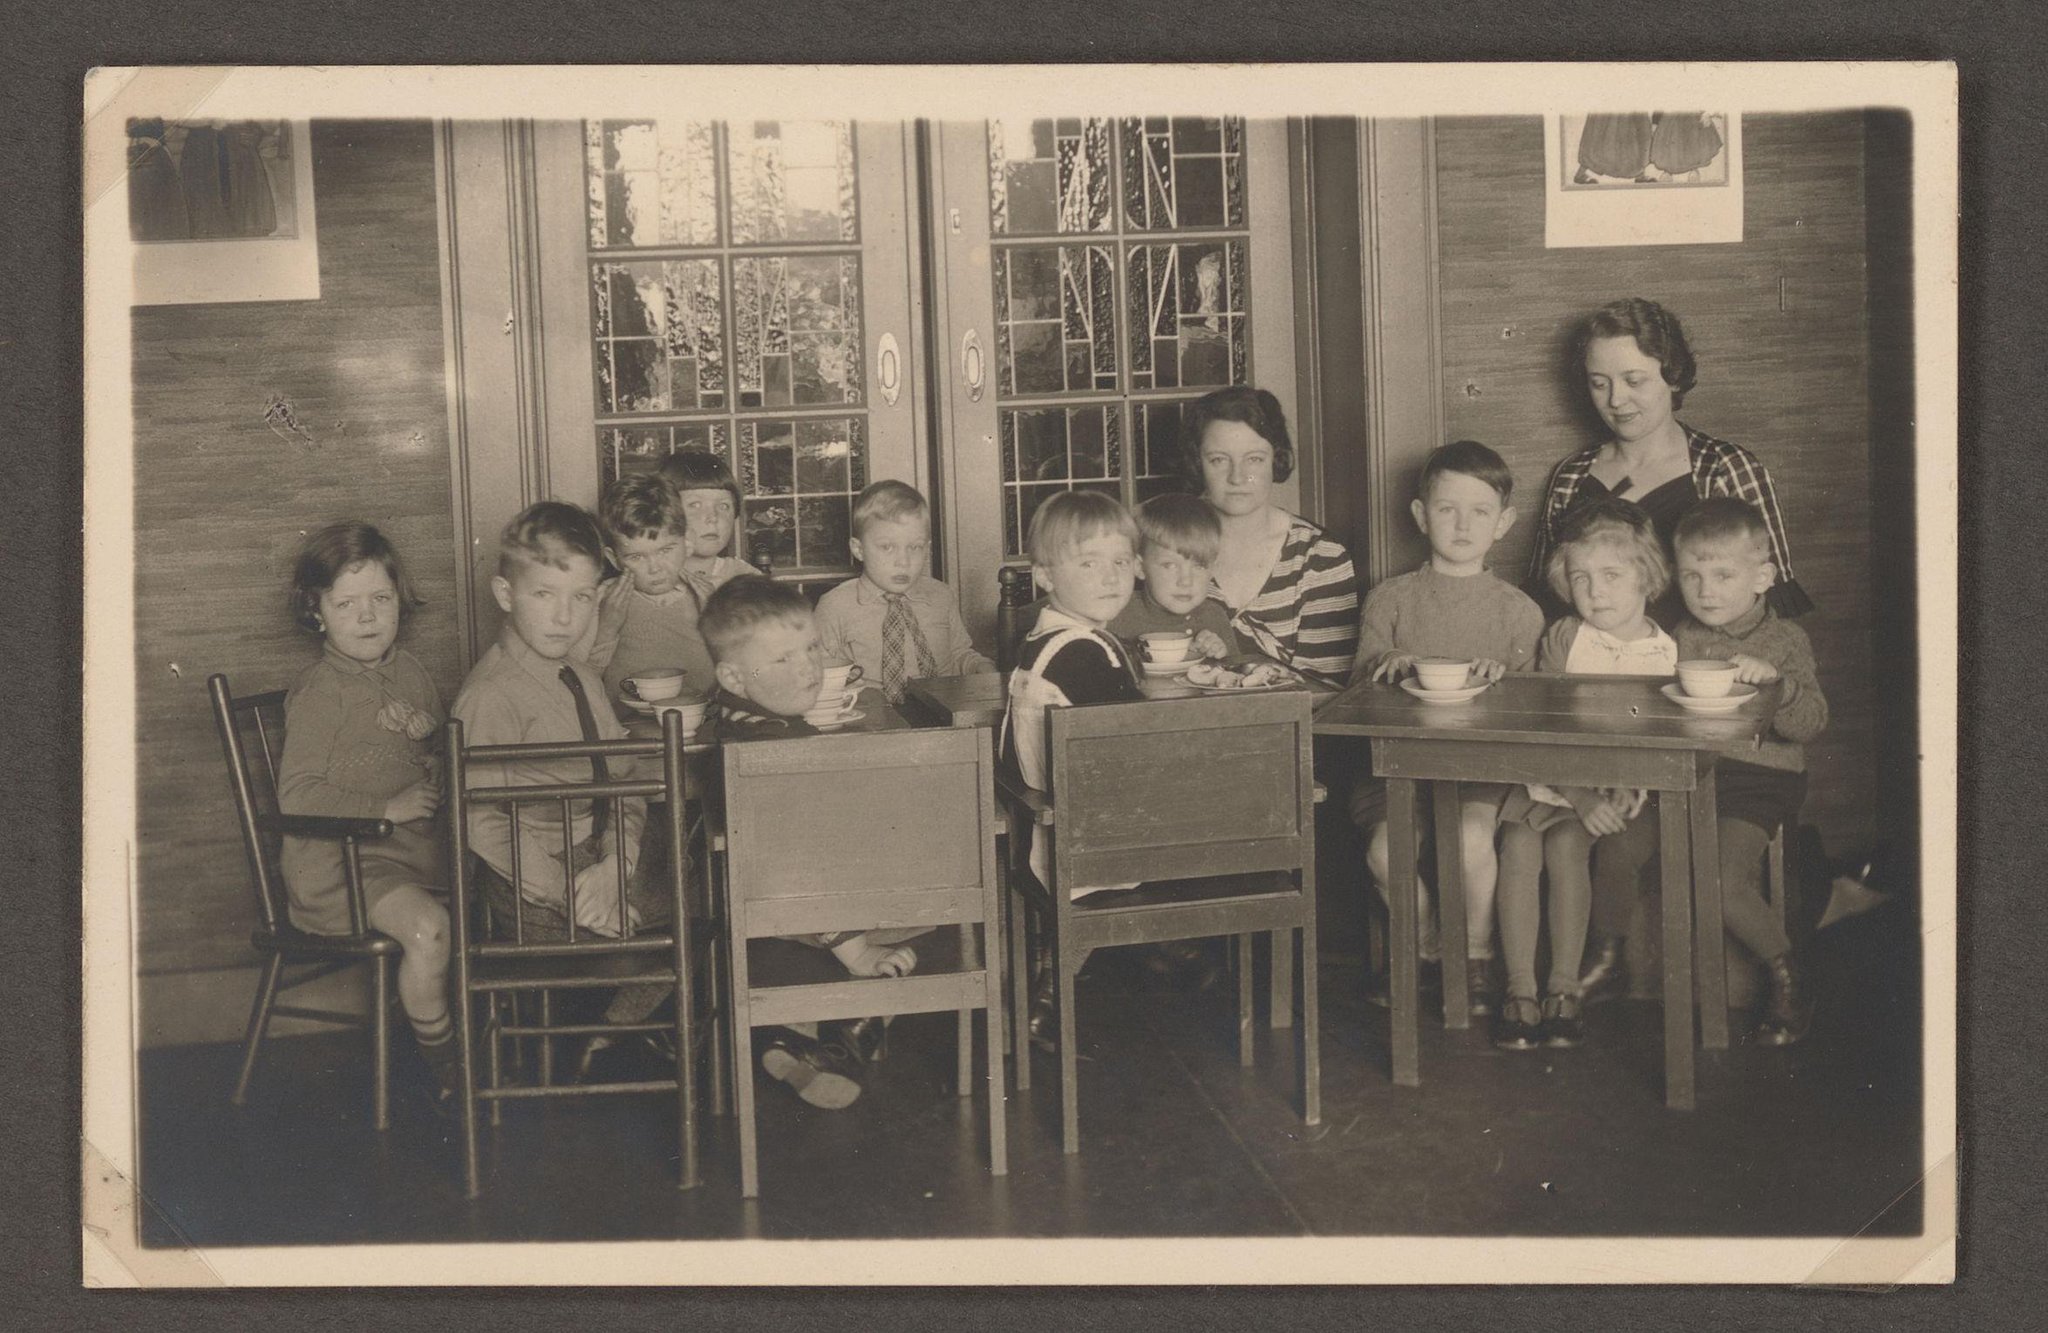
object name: photograph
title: Schoolklas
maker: françois louis alphonse marie eiffert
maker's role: fotograaf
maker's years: 1890-1942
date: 1932-1942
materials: cardboard, photographic support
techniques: gelatin silver print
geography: schiedam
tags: elementary school; class, form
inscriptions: name: ‘Foto Eiffert / Burg. Knappertlaan 193 / Schiedam’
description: Albumblad met een foto van een schoolklas van Nederlandse kinderen zittend aan een tafel, met twee onderwijzeressen. Onderdeel van het ensemble van albumbladen en losse foto's over ingenieur Jetten en familie in Moengo, Suriname.